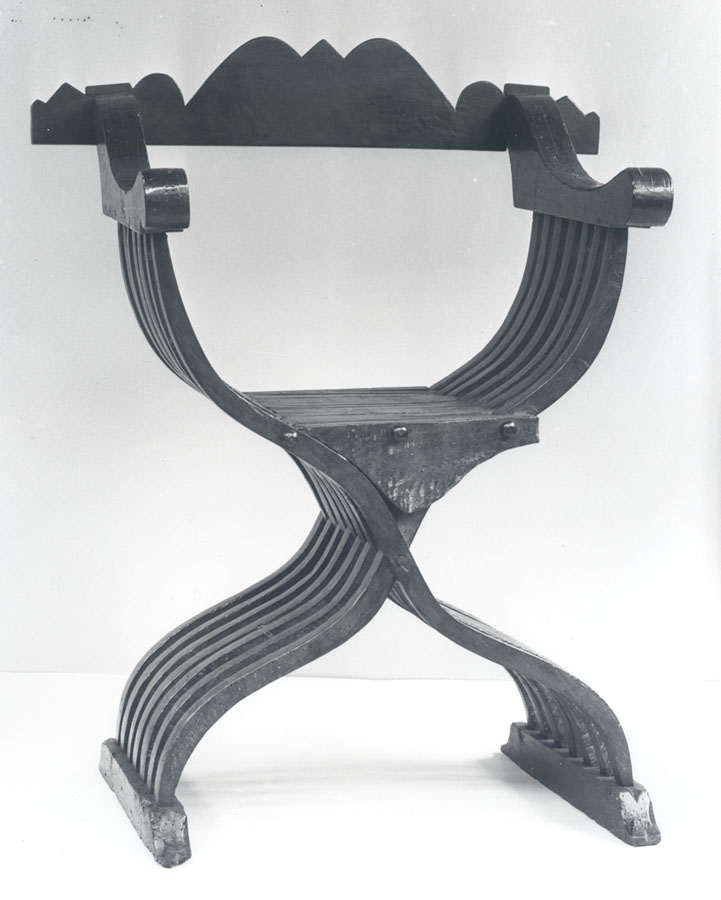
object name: chair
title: Savonarola Chair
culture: italian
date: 1401-1600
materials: wood